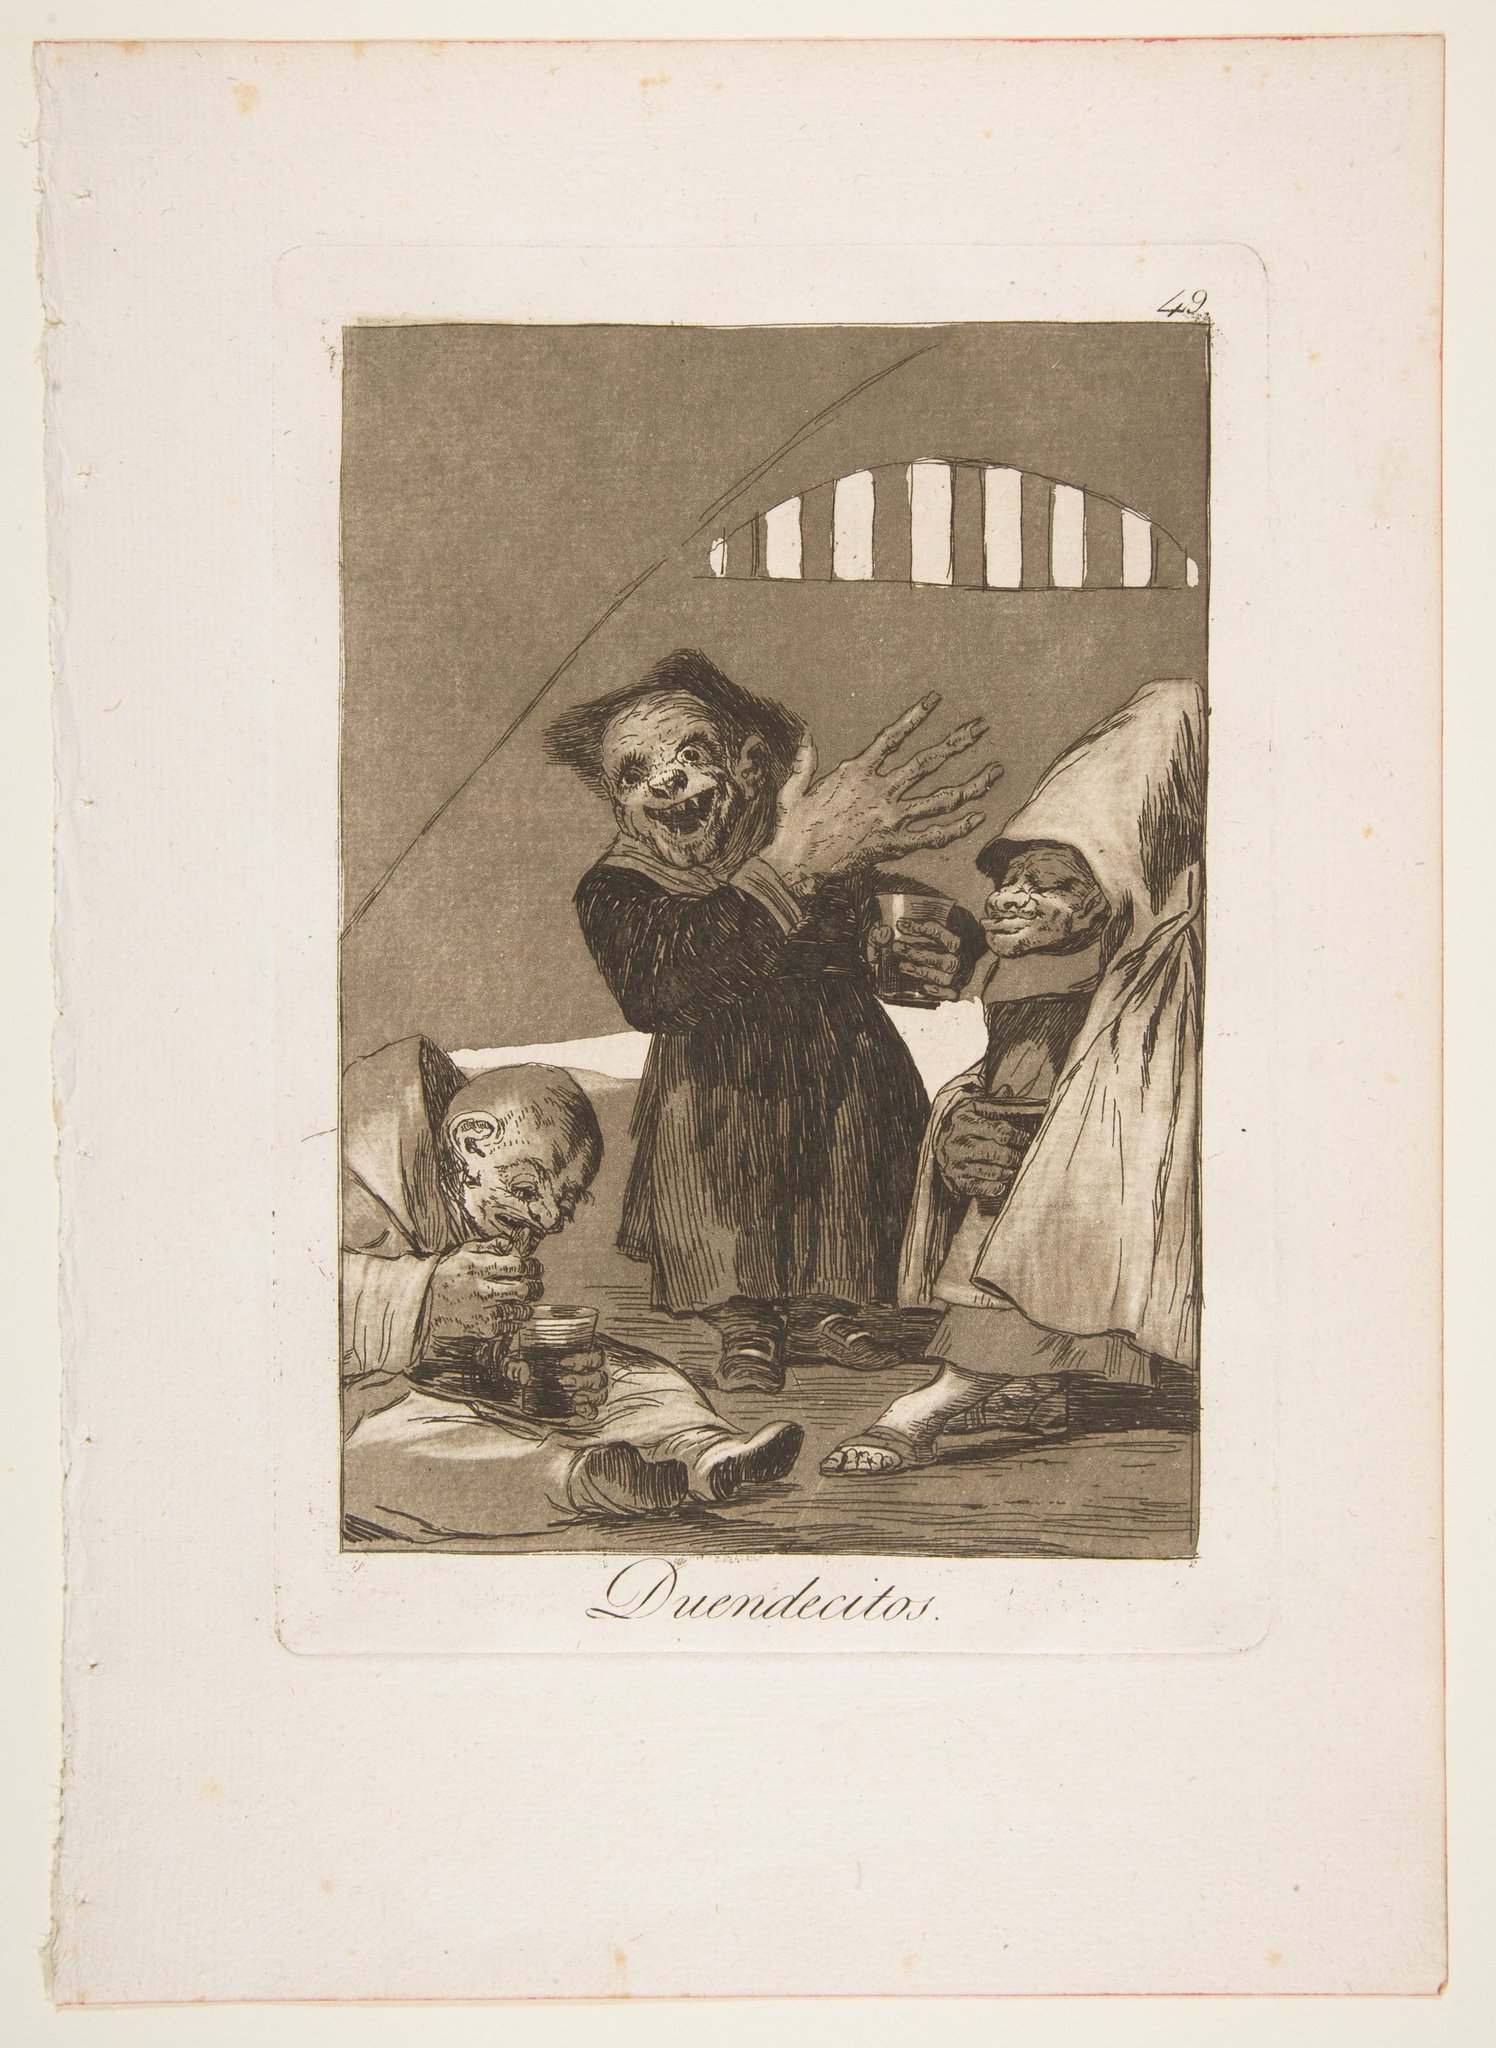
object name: print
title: Plate 49 from "Los Caprichos": Hobgoblins (Duendecitos)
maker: goya (francisco de goya y lucientes)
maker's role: artist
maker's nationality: spanish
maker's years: 1746-1828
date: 1799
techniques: aquatint, burnishing, etching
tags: mythical creatures